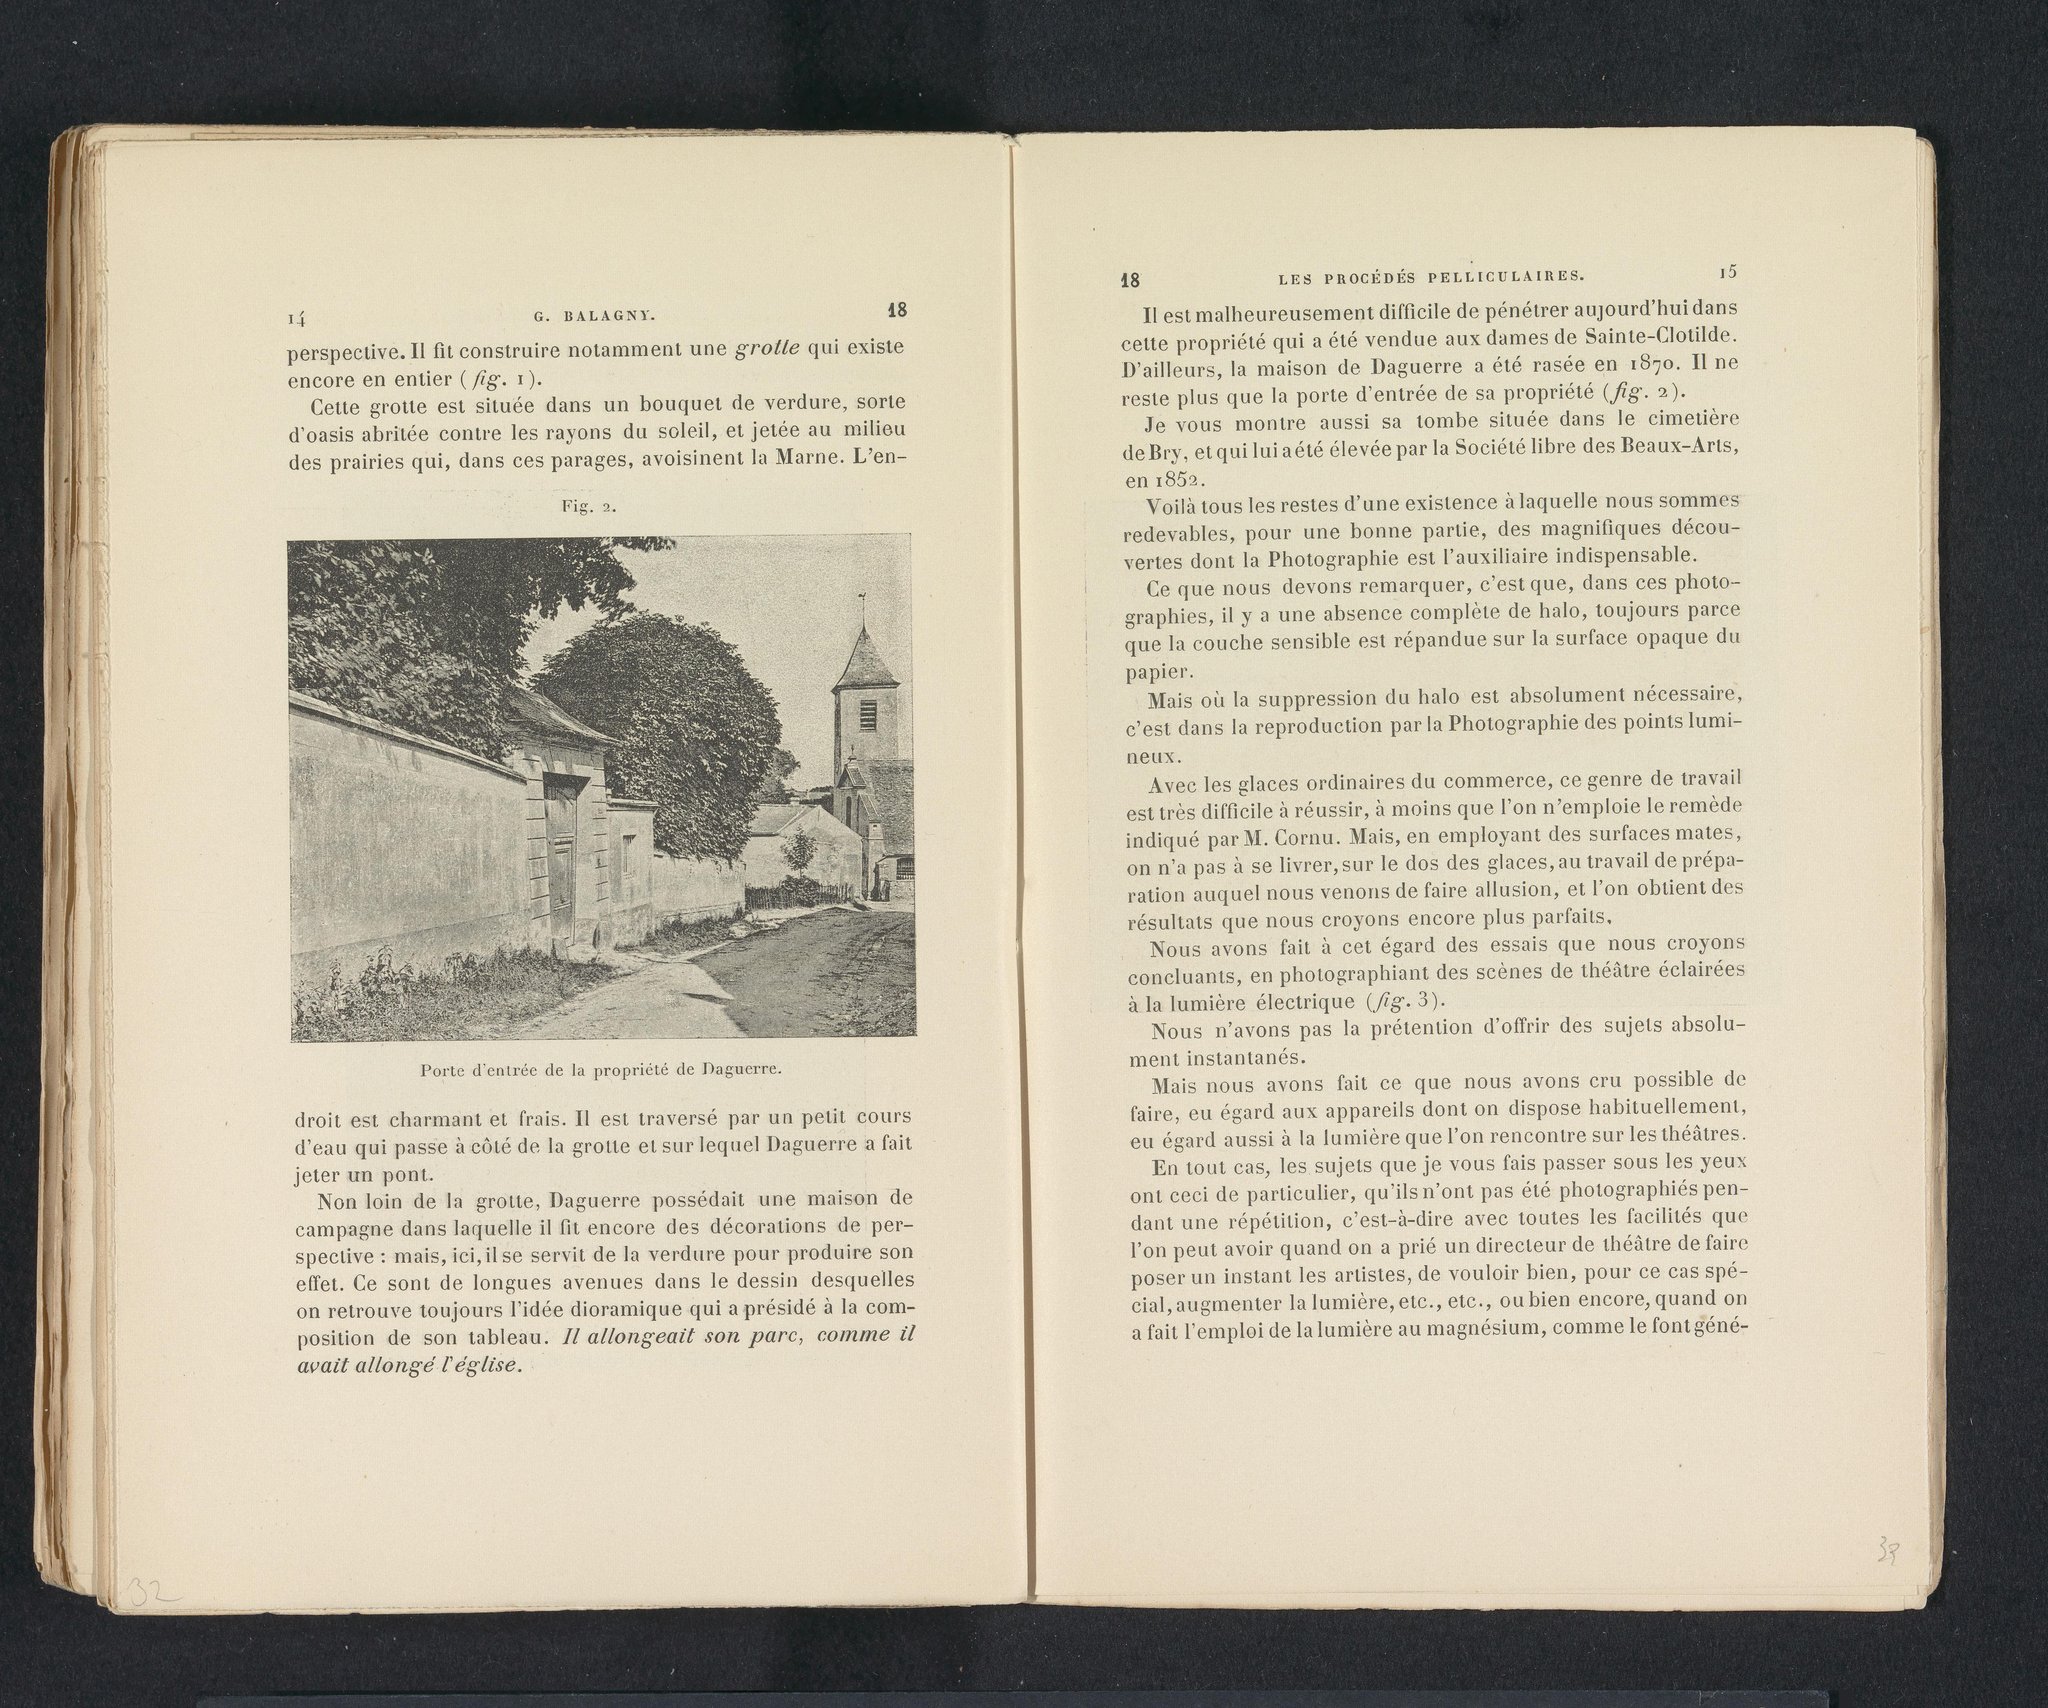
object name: photomechanical print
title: Toegangsportaal van het huis van Louis Daguerre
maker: Anonymous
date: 1883-1893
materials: paper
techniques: autotype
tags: fence, wall, paling, gate, entrance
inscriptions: number: ‘Fig. 2.’, inscription: ‘Porte d'entrée de la propriété de Daguerre.’